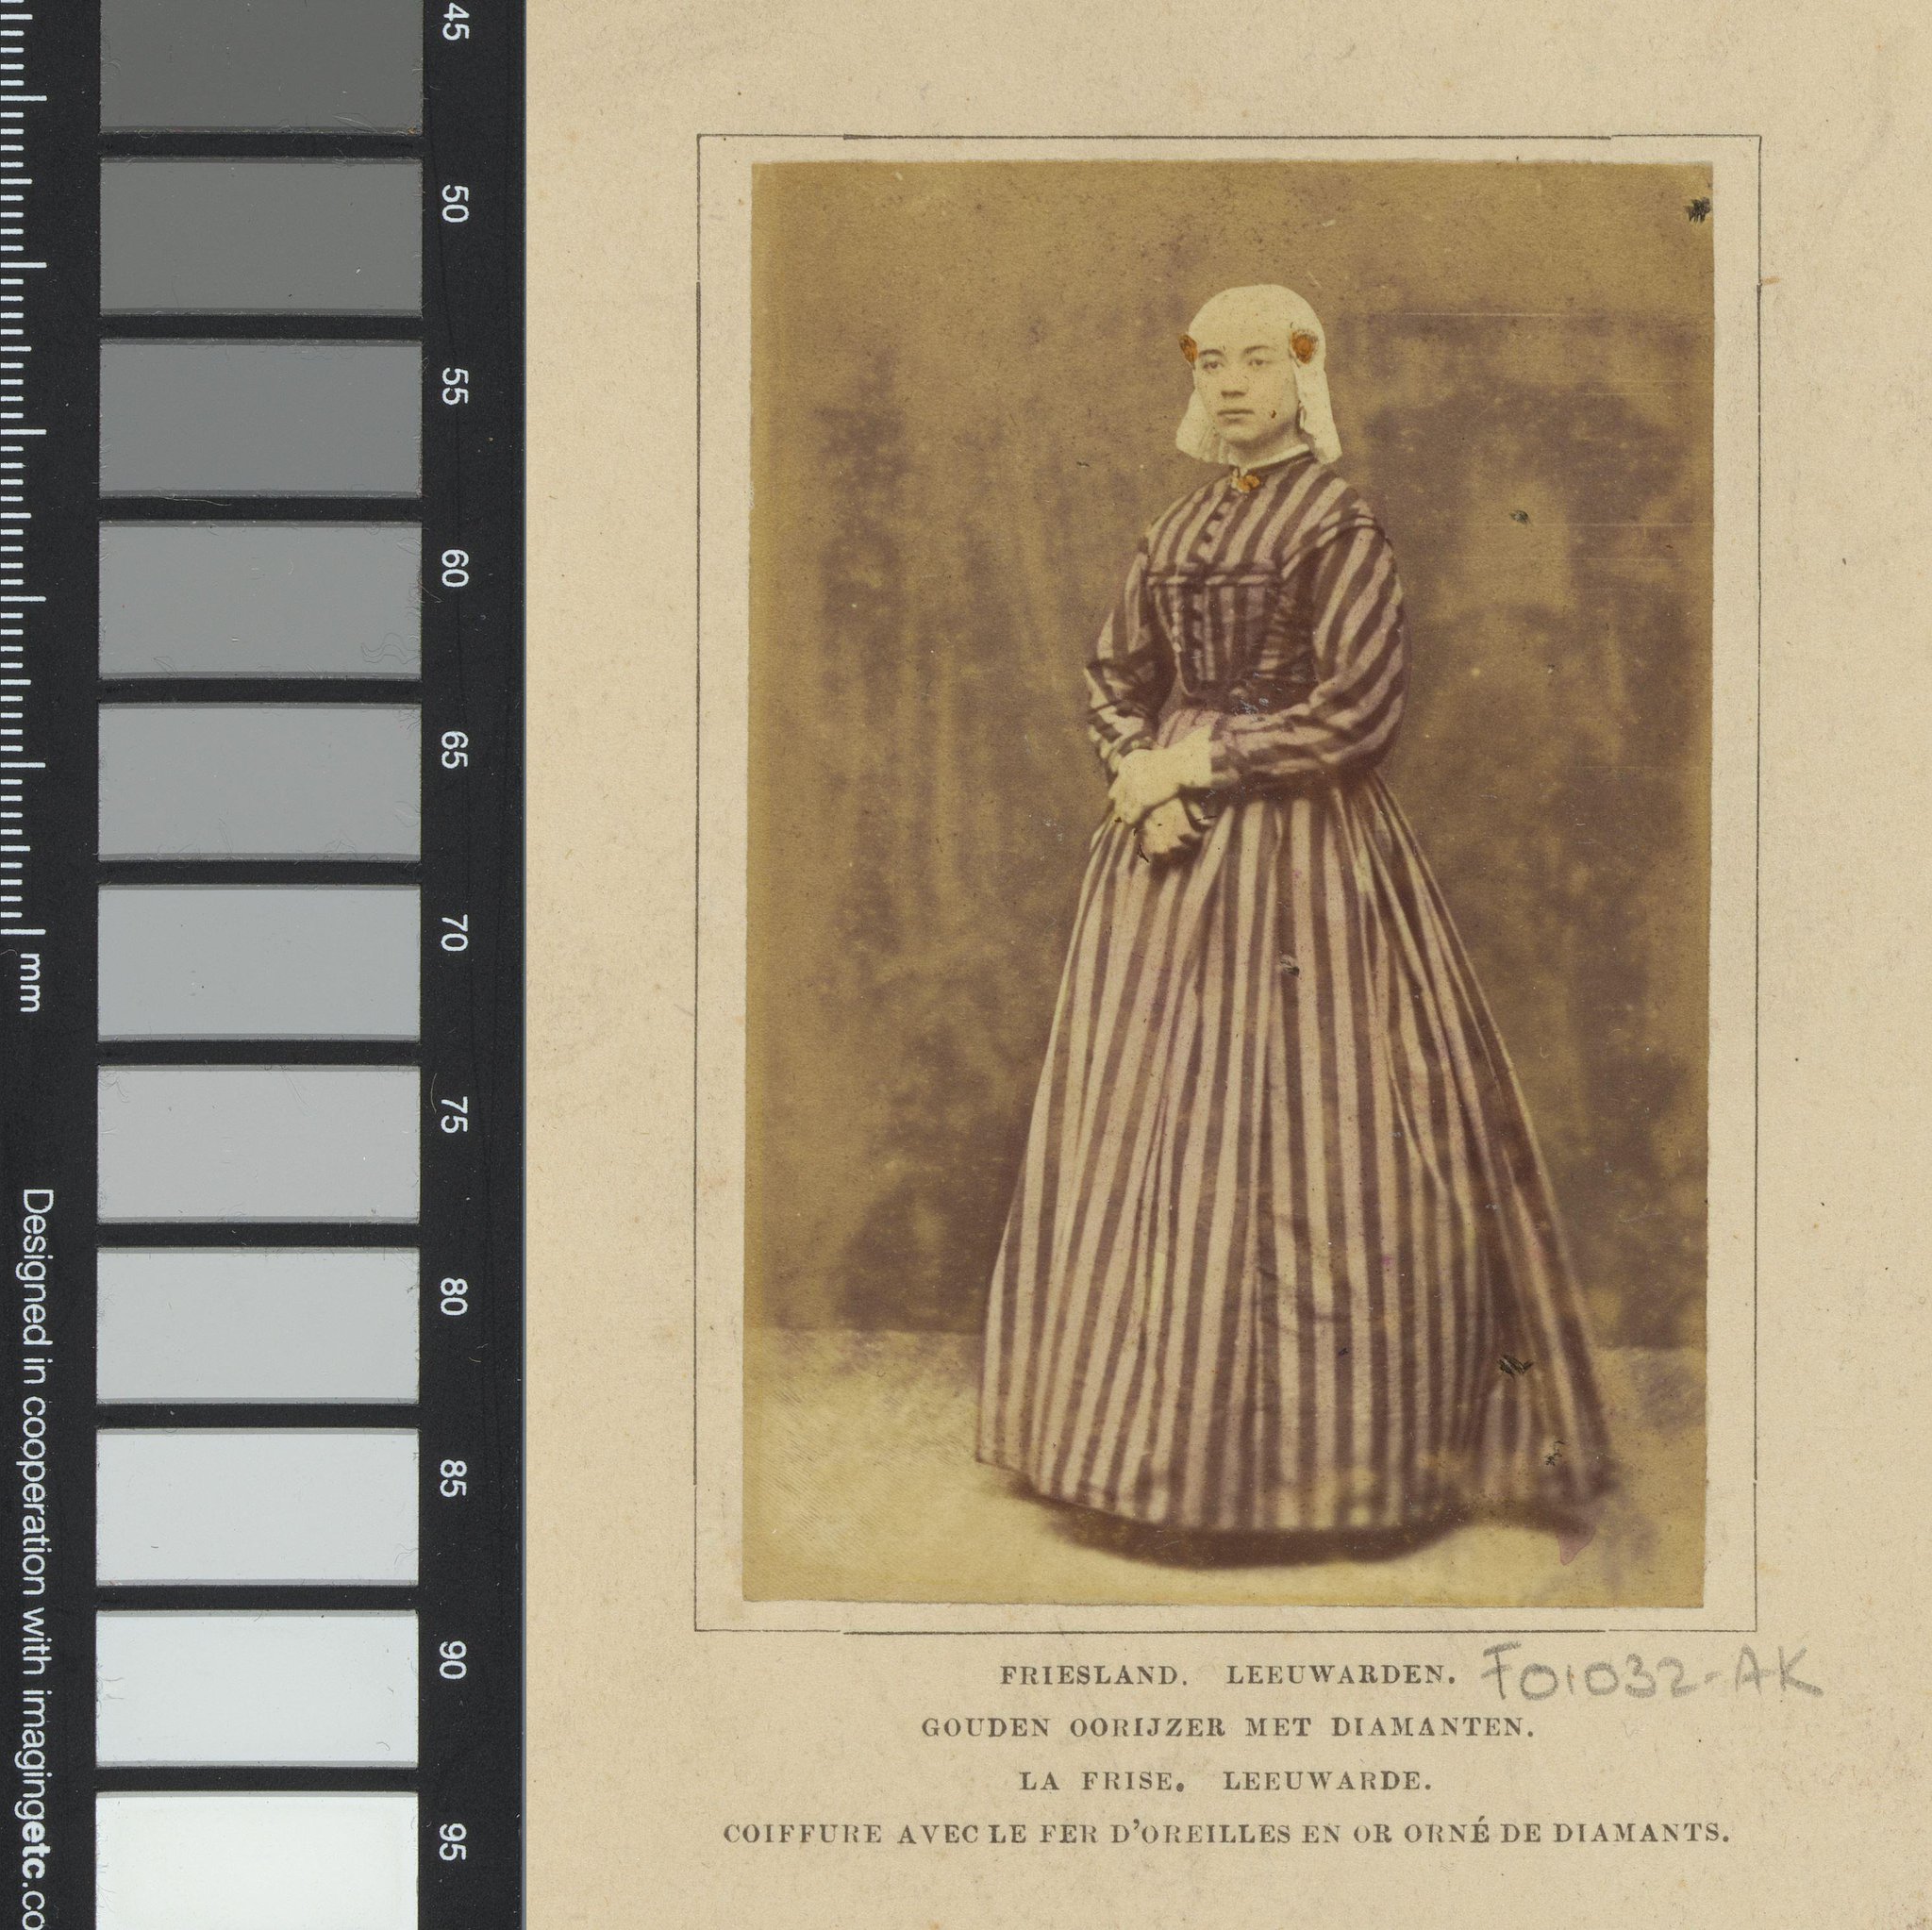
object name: photograph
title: La Frise. Leeuwarde. Coiffure avec le fer d'oreilles en or orné de diamants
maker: andries jager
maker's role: publisher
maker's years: 1825-1905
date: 1860-1890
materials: cardboard, photographic support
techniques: albumen print, hand coloring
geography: amsterdam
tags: folk costume, regional costume (+ women's clothes), historical persons - bb - woman, europeans (with name), netherlands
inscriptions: inscription: ‘Uitgave van A. JAGER, Water 110 te Amsterdam.’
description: Deze foto maakt deel uit van een omslag met 48 foto's op 12 bladen.